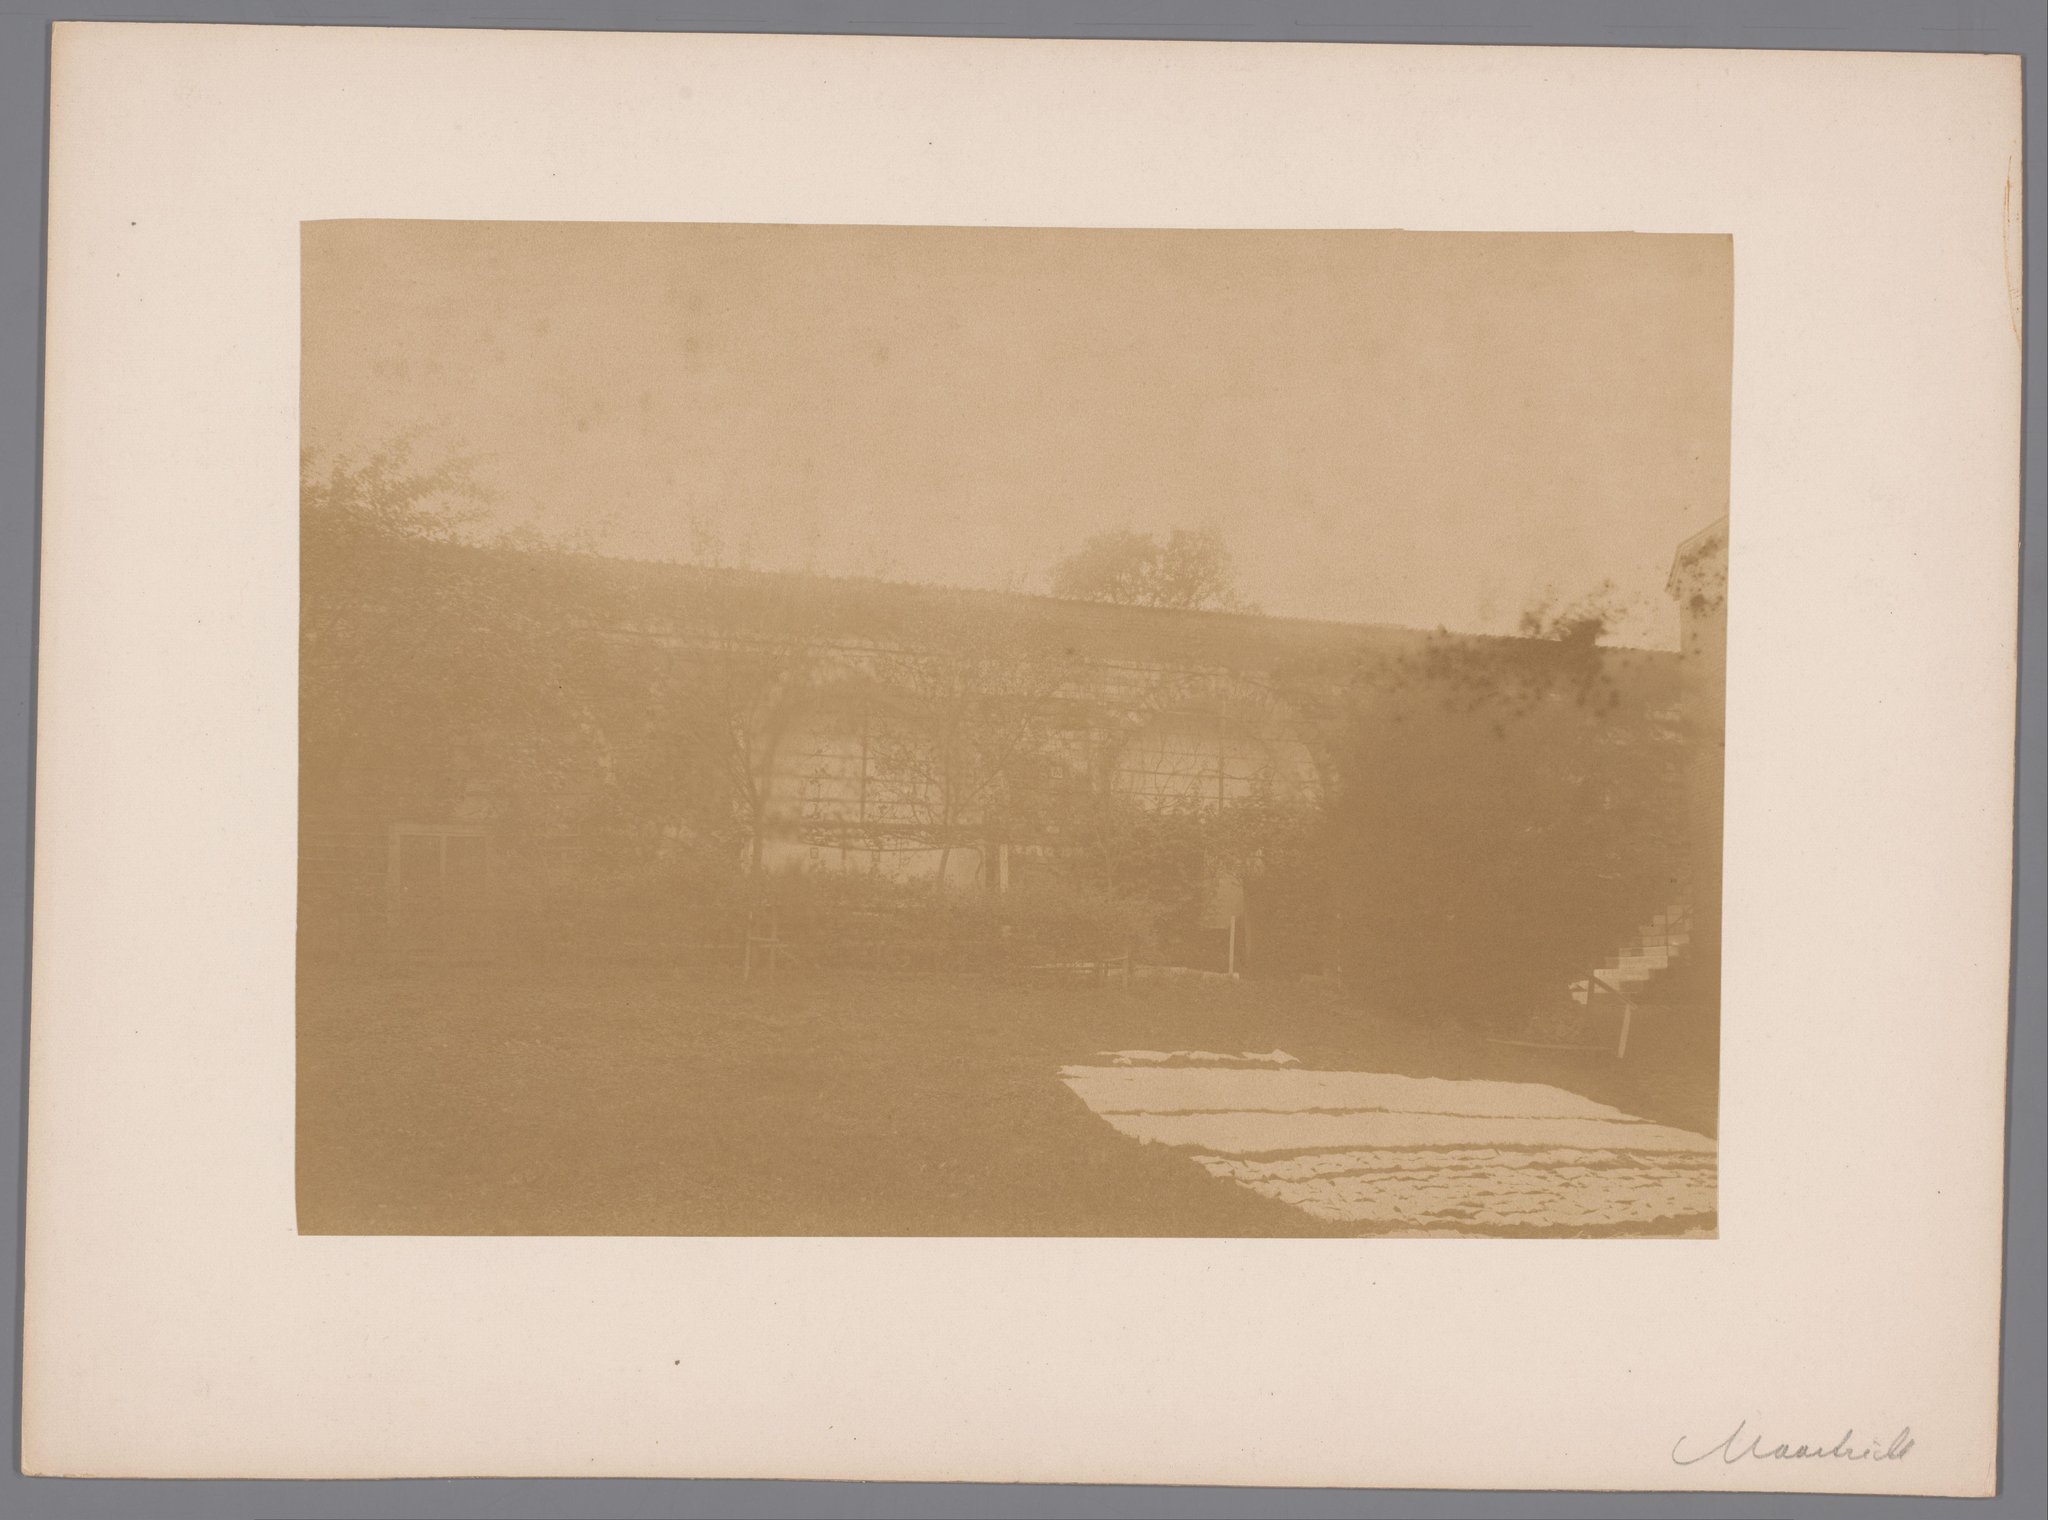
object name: photograph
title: Gezicht op de oude walmuur in de tuin van de Zusters onder de bogen te Maastricht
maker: anoniem (monumentenzorg)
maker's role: fotograaf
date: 1898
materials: cardboard, photographic support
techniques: albumen print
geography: zusters onder de bogen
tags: garden, city-walls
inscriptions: annotation: ‘Oude walmuur (stadszijde)/ in de tuinen der Zusters onder de bogen te Maastricht (L.)/ oct 1898’, annotation: ‘Maastricht’